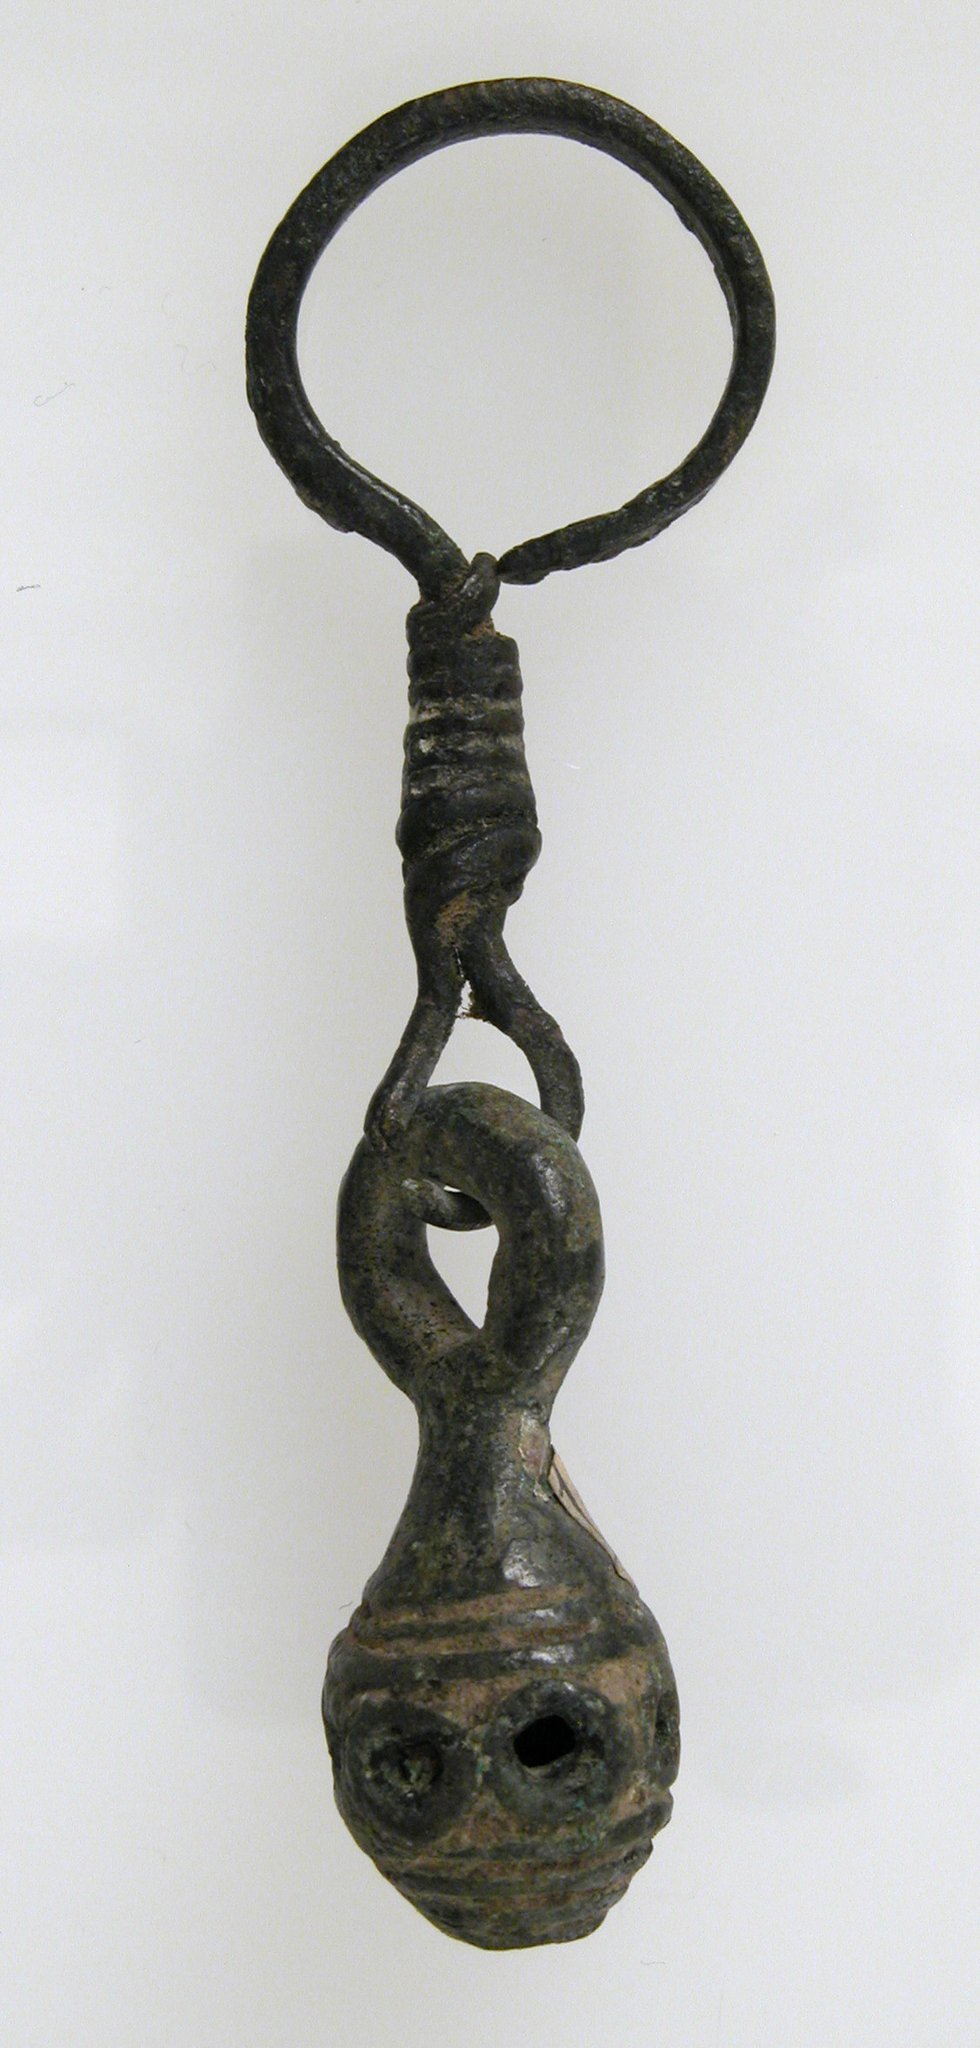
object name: pendant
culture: roman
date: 401-800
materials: copper alloy, glass, paste